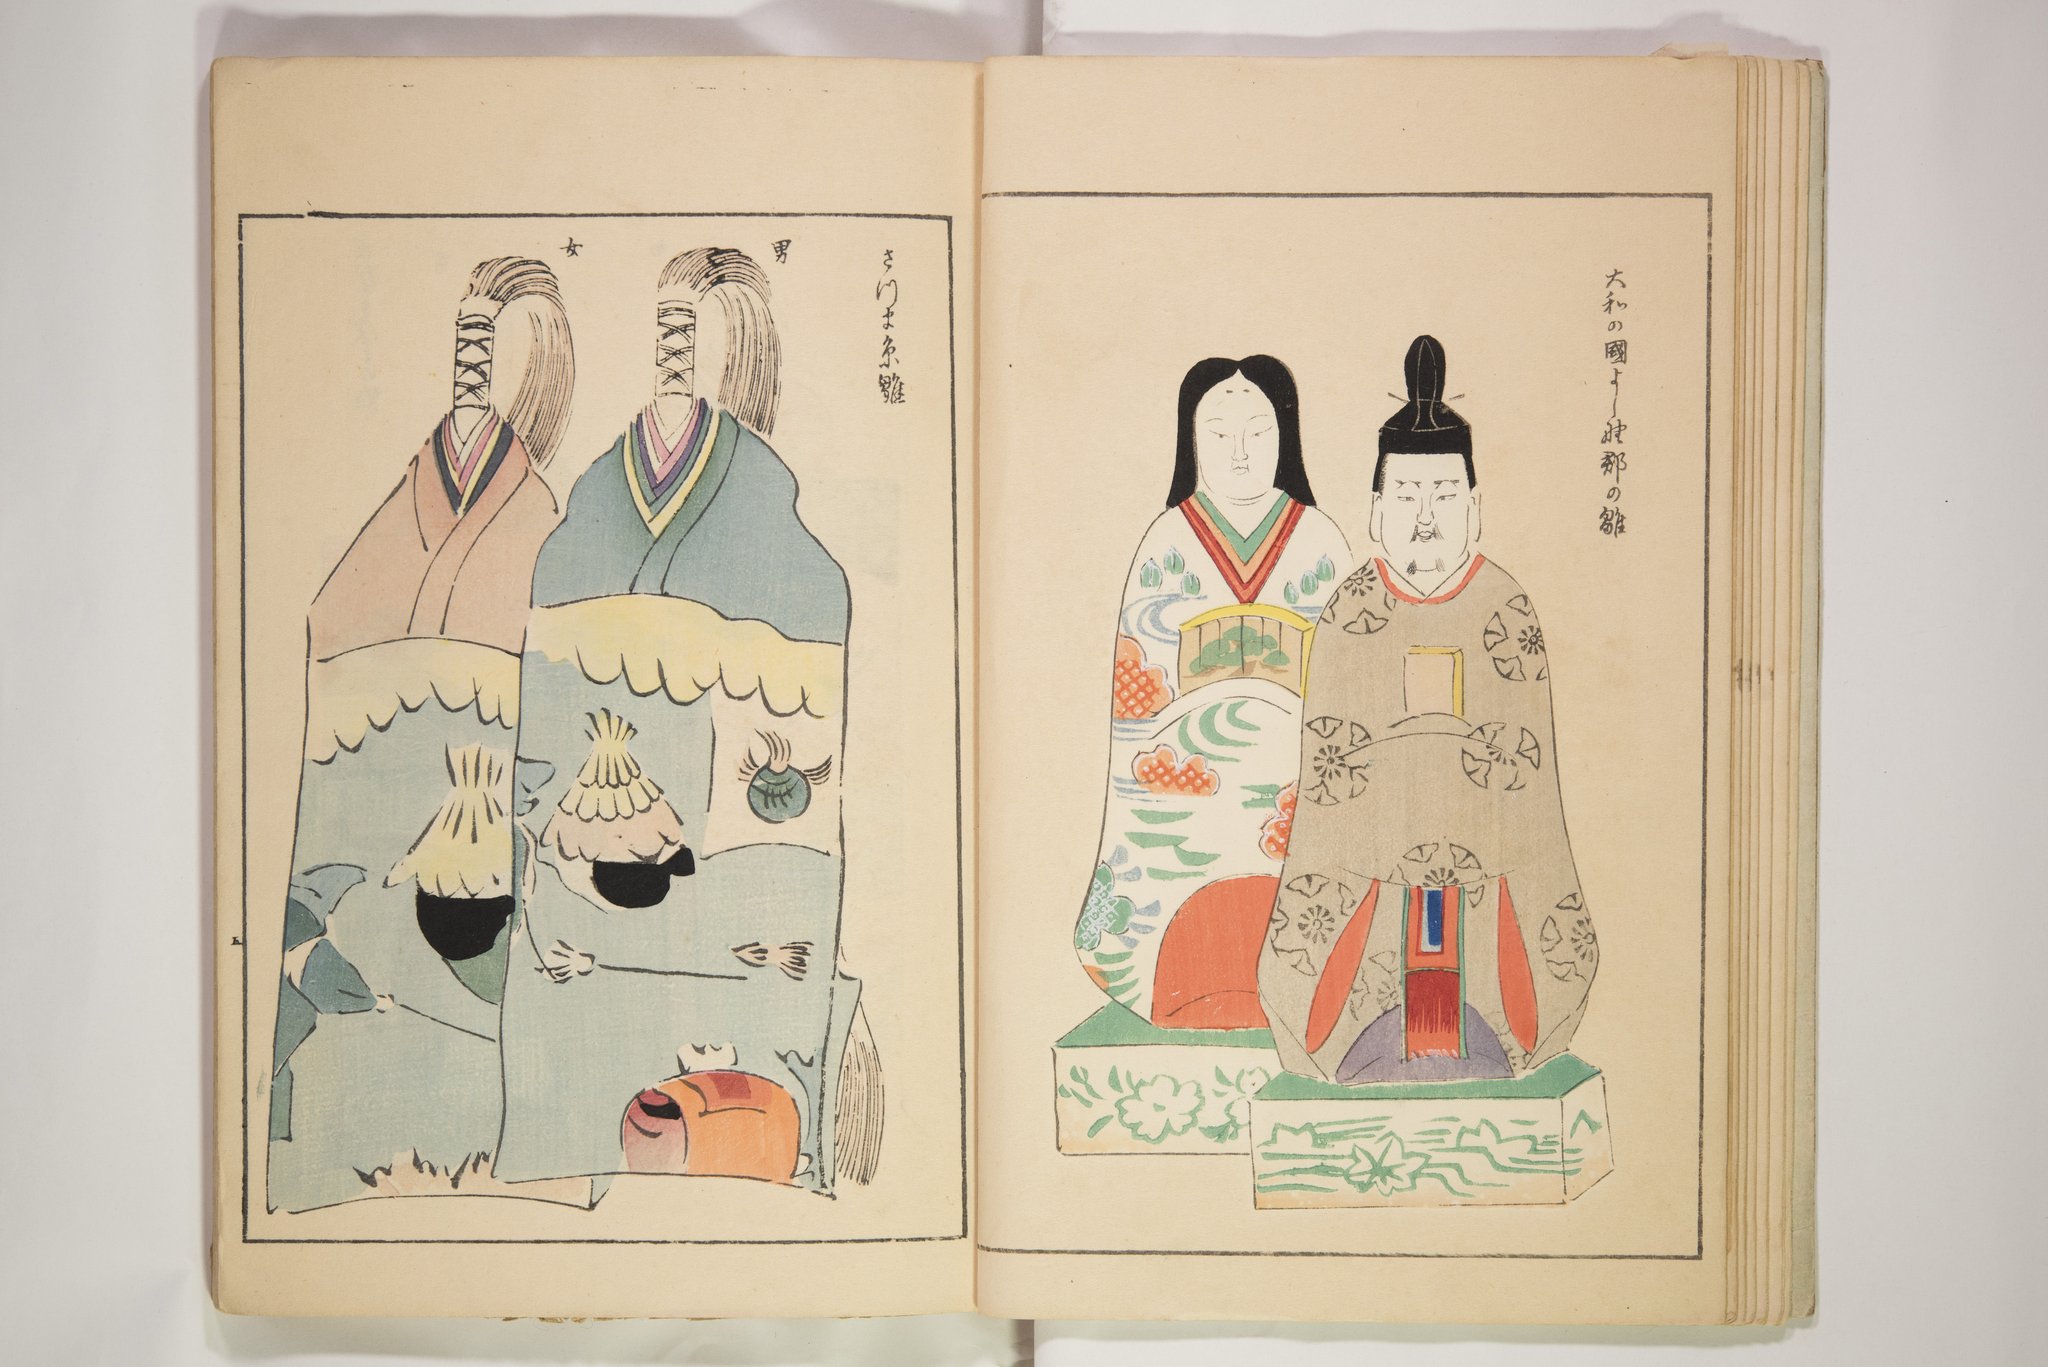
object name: illustrated book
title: Book of Toys (Unai no to mo) うないのとも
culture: japanese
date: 1891-1924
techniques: polychrome, woodblock print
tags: men,women